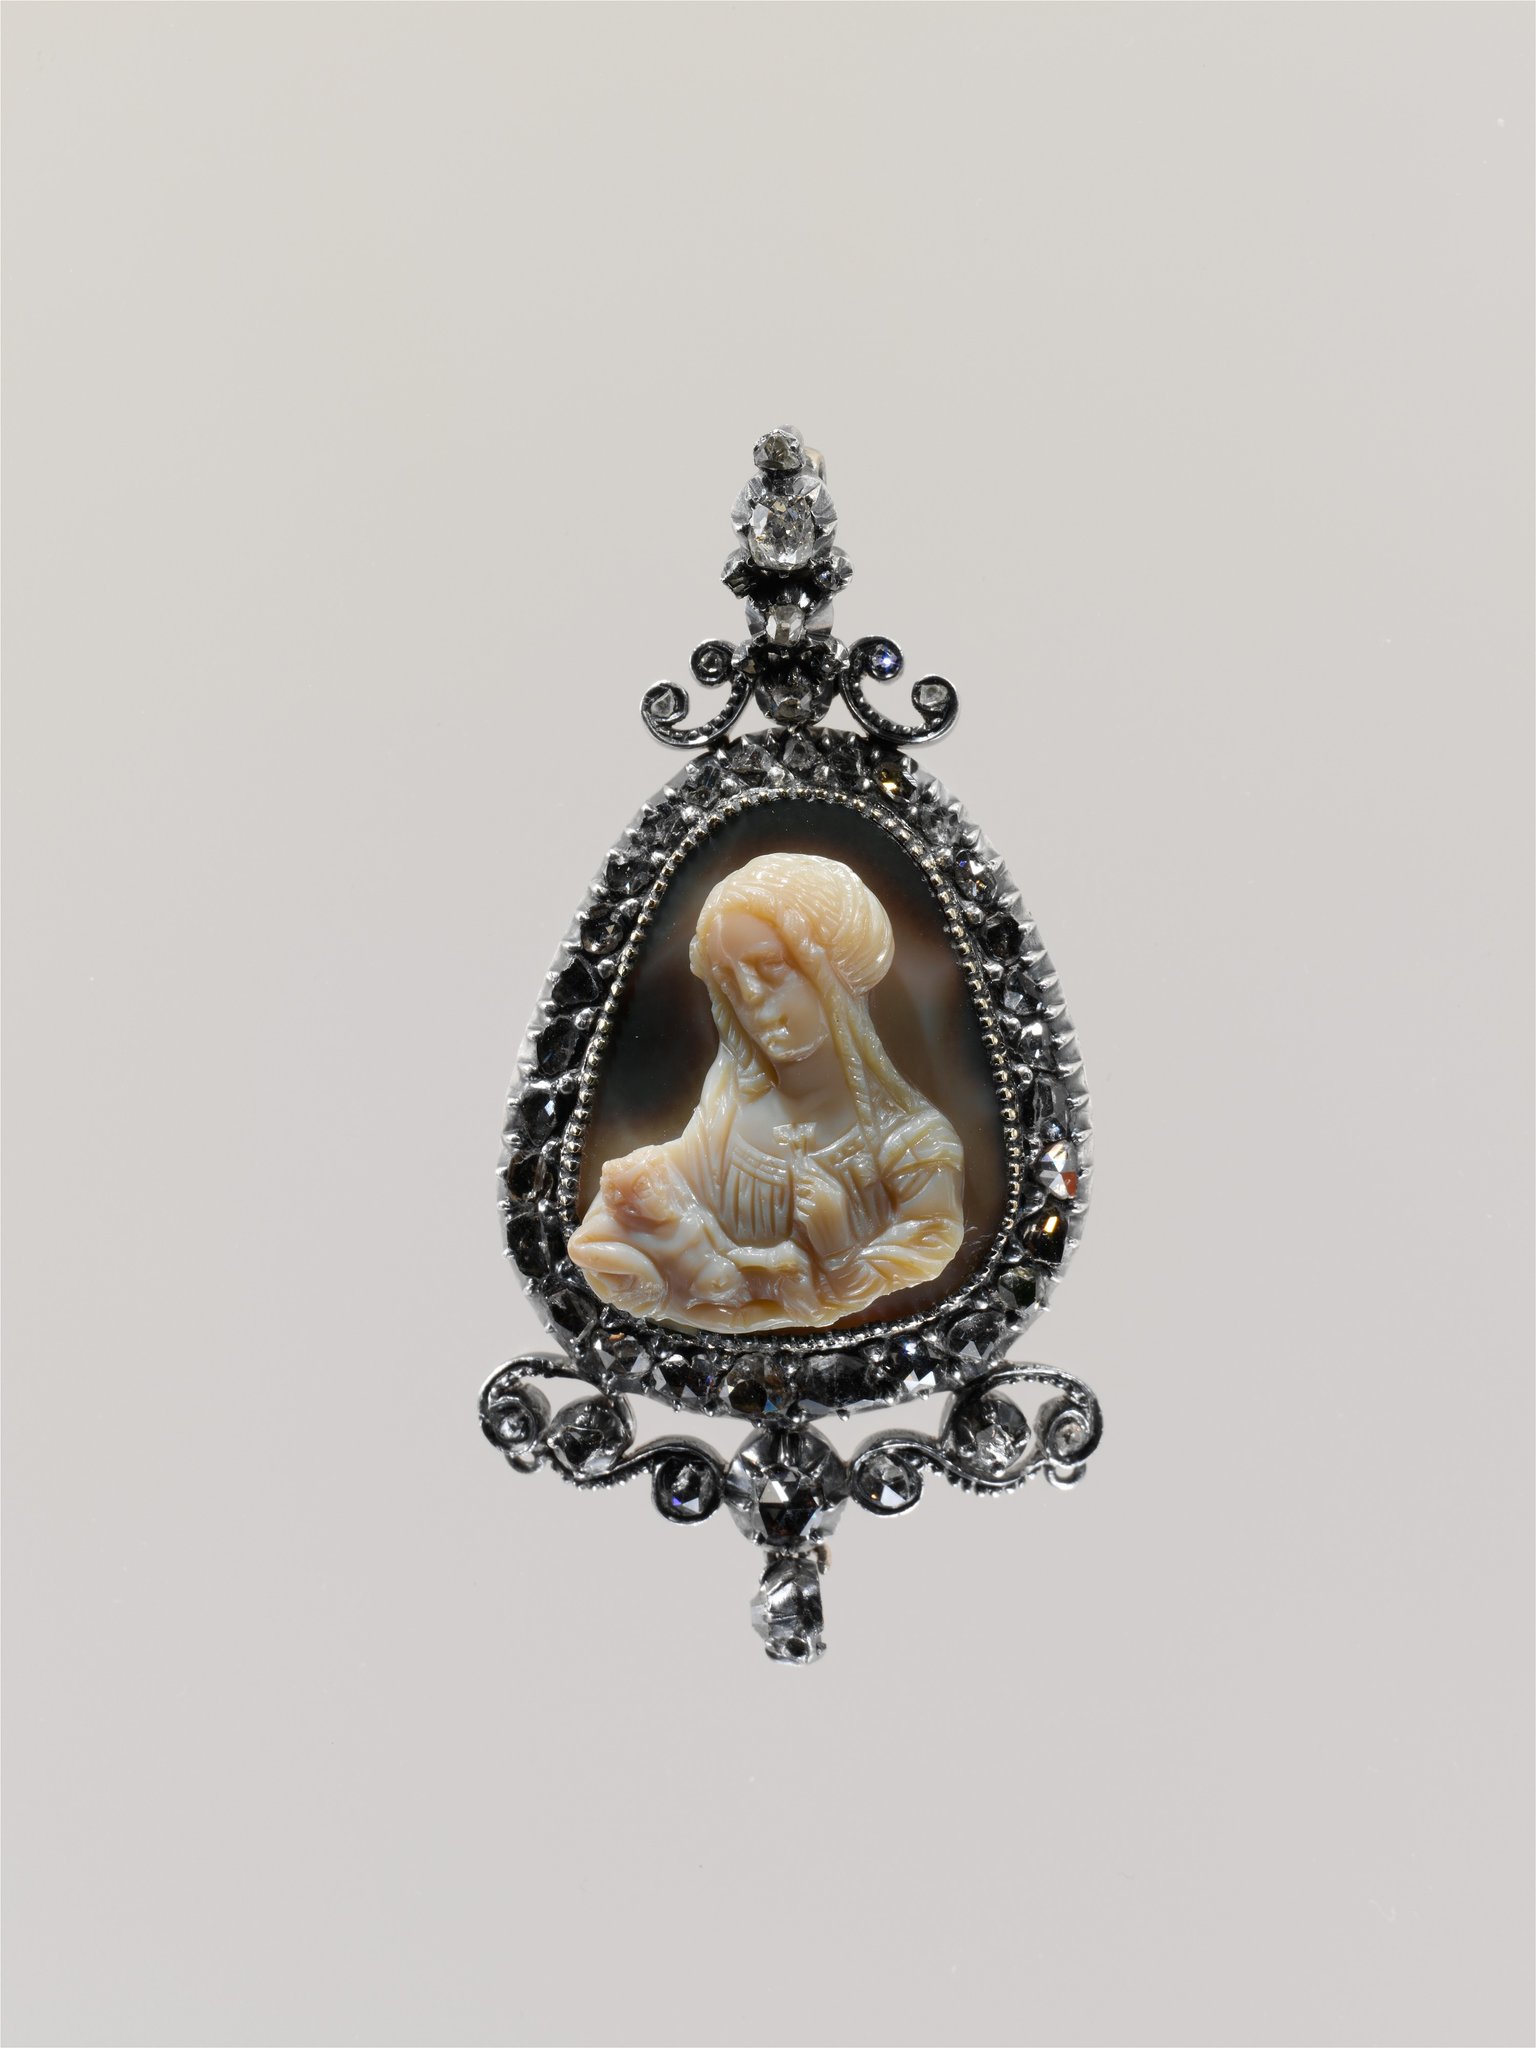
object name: cameo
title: Madonna and Child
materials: diamond, gemstone, silver gilt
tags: madonna and child